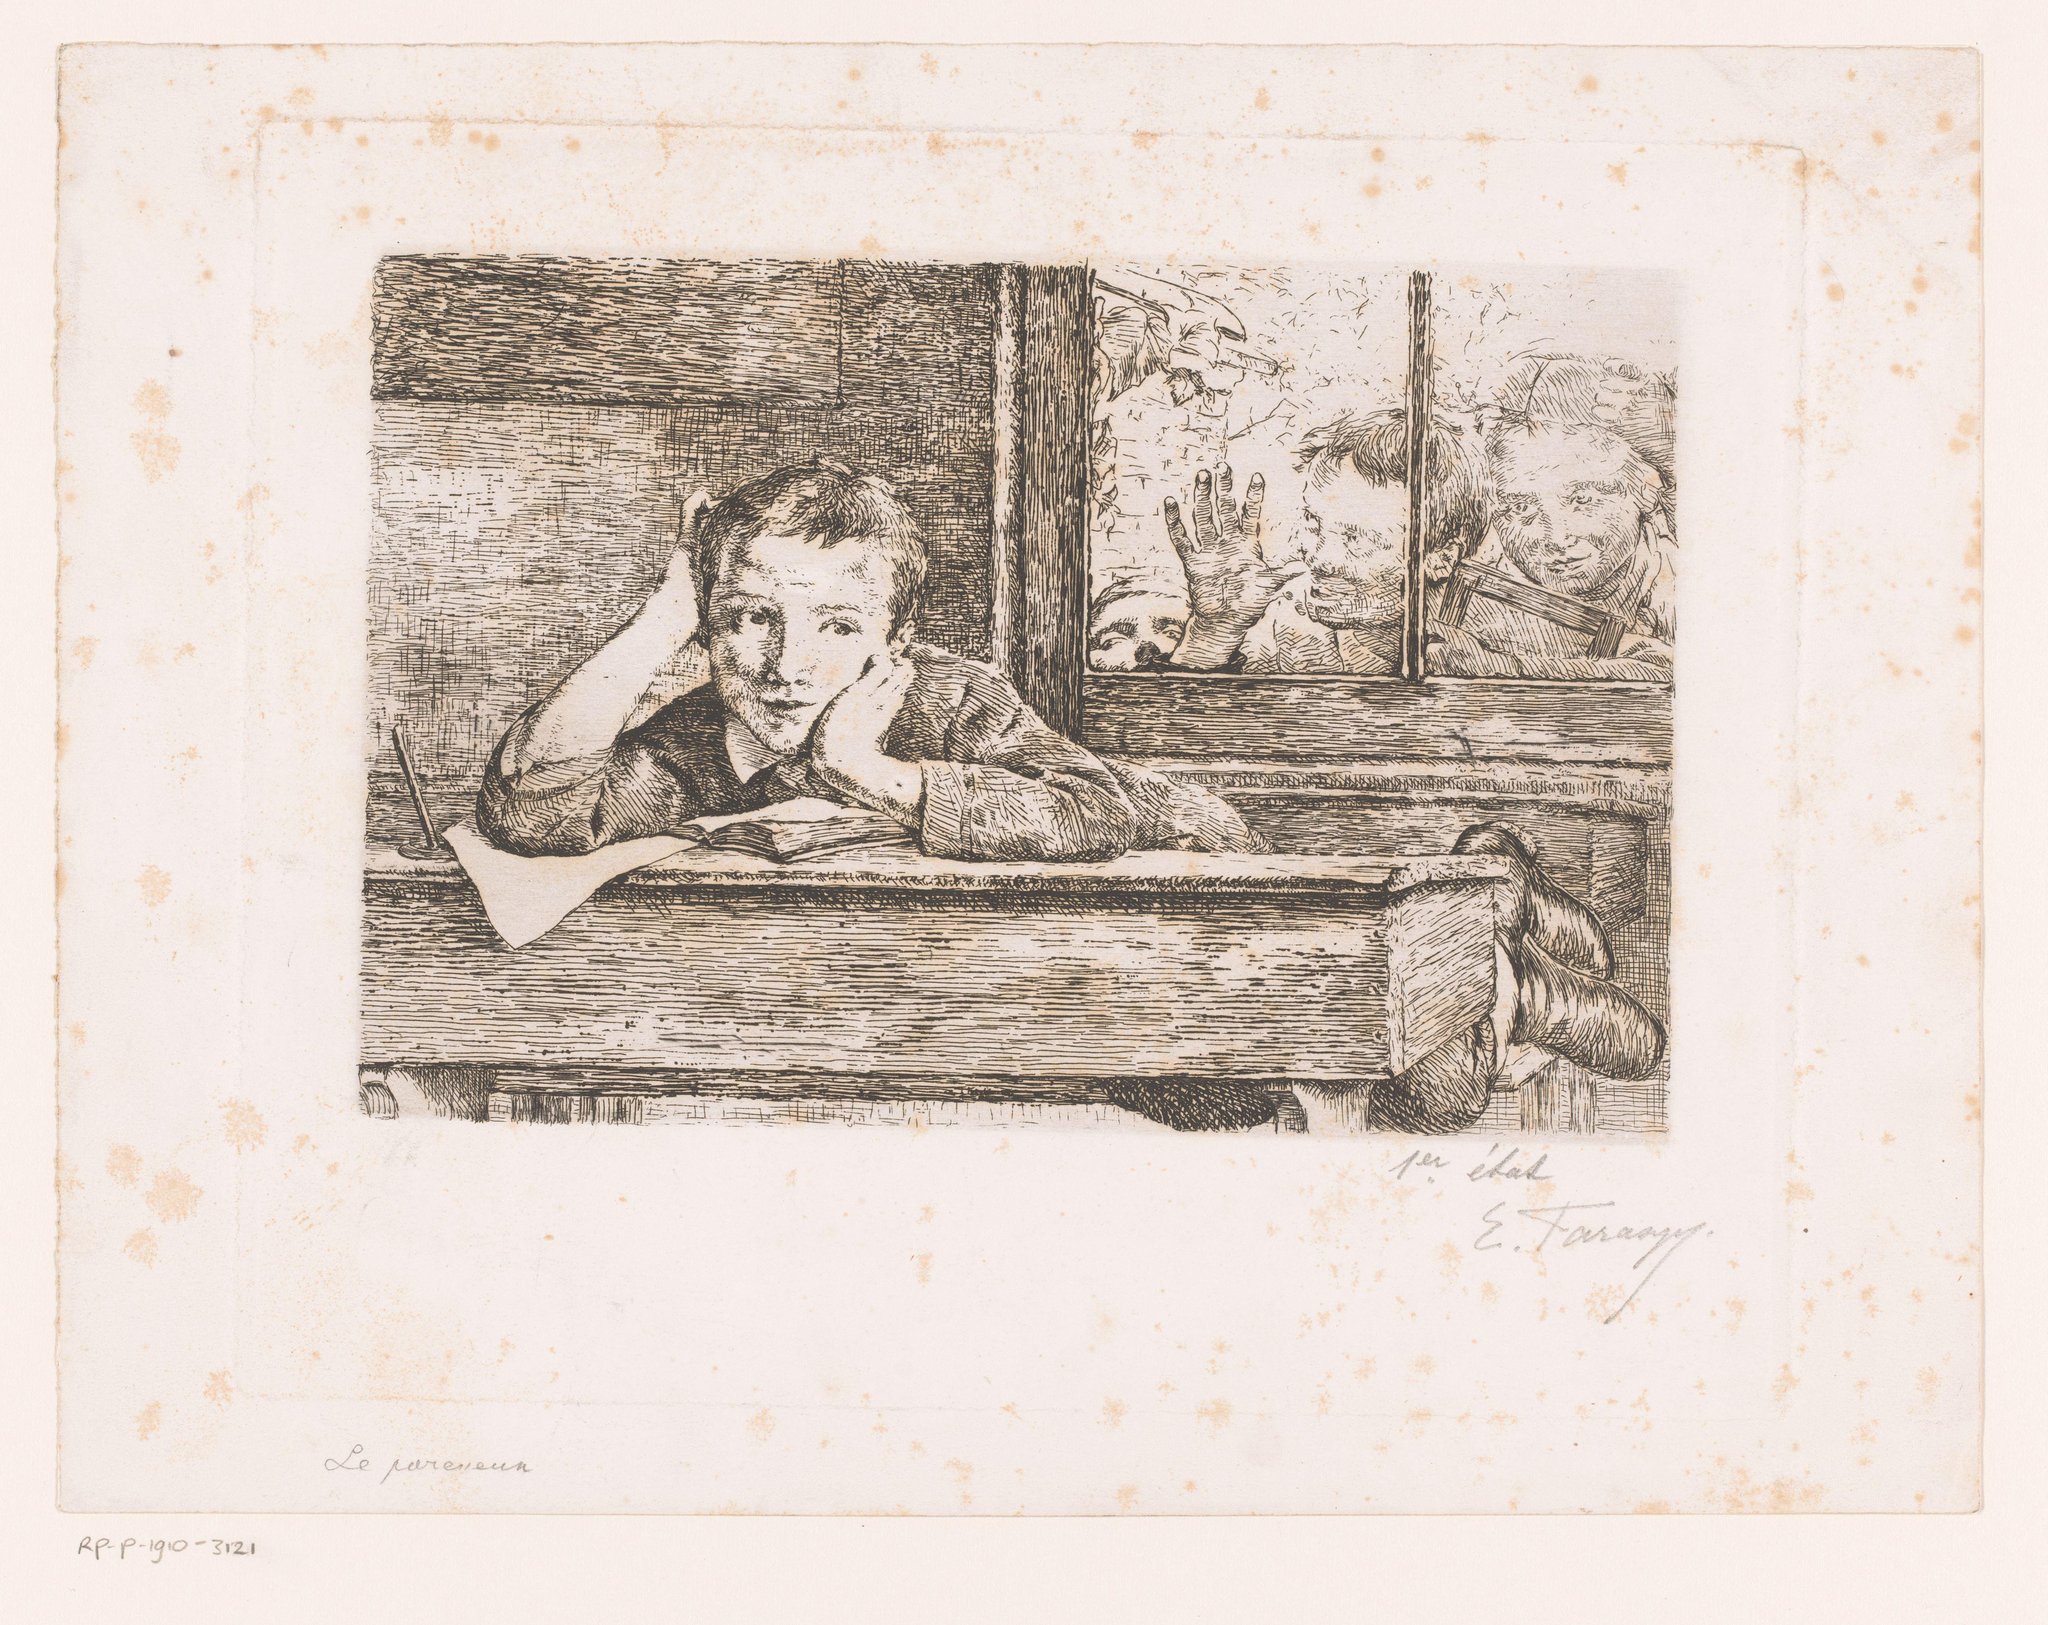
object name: print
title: Drie kinderen kijken door een raam naar een jongen die over een schoolbank hangt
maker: edgard farasyn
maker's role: print maker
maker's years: 1858-1938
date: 1868-1910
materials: paper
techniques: etching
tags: writing-table, writing-desk, child (+ four persons), closed window, elementary school; class, form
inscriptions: collector's mark: Lugt 2228, inscription: ‘Le [pareveua]; 1er état’